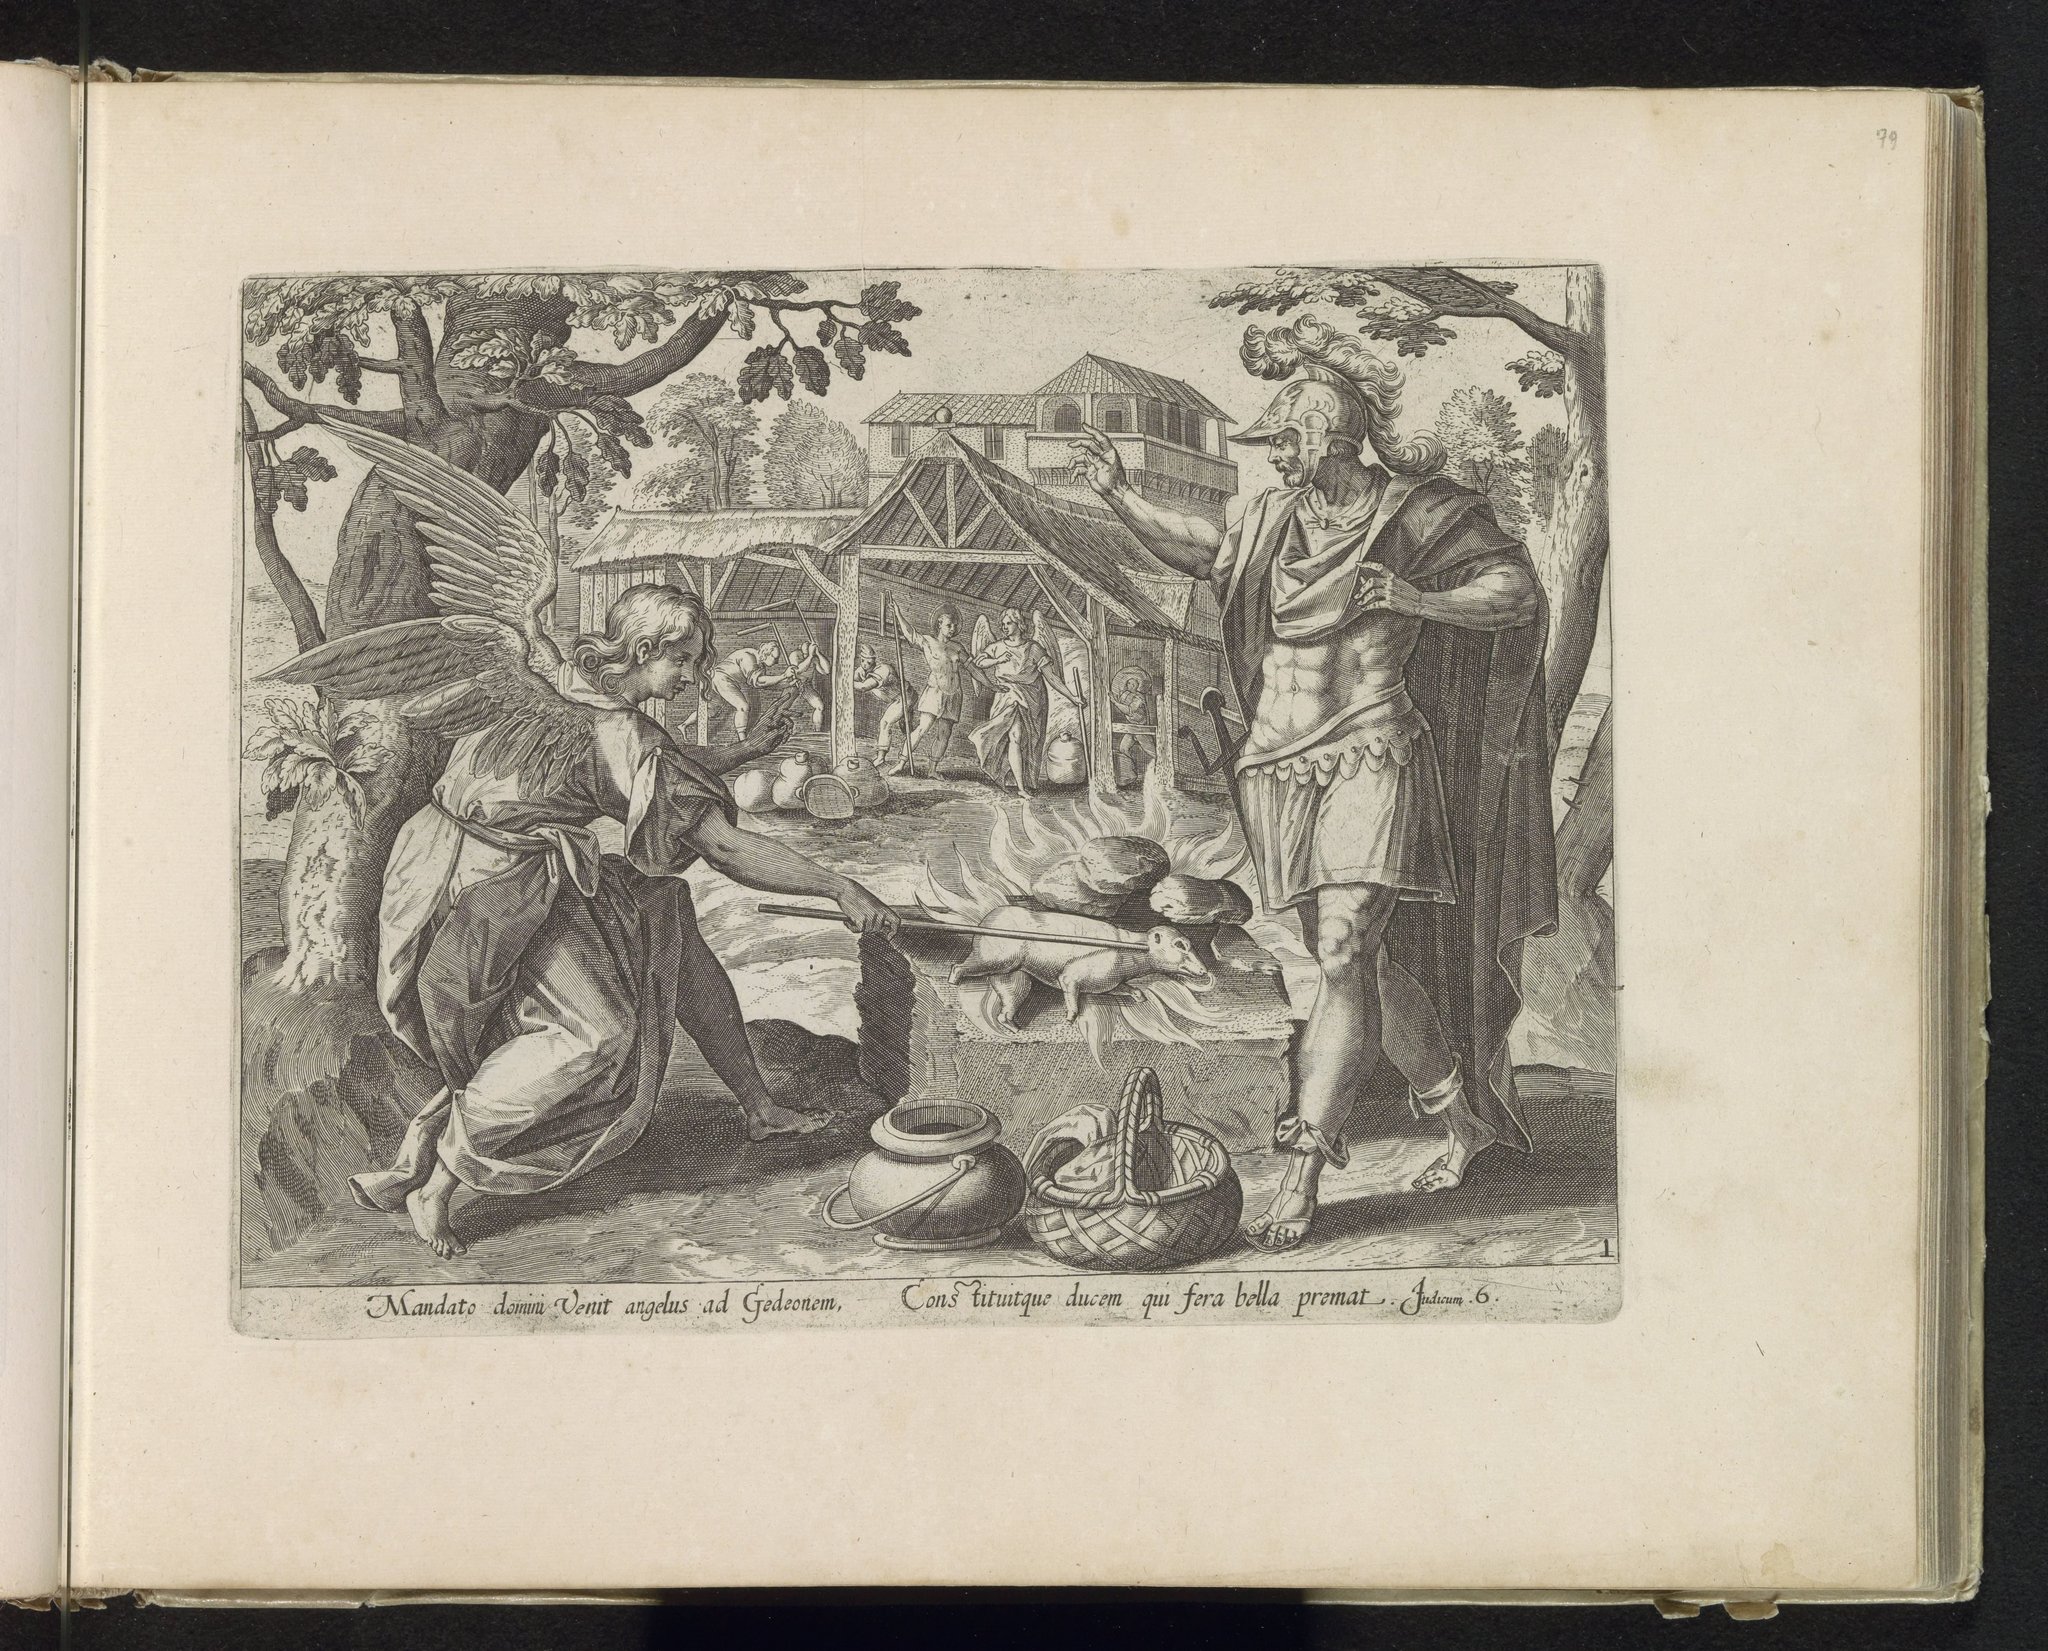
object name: album leaf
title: Thesaurus sacrarum historiaru[m] veteris testame[n]ti, elega[n]tissimis imaginibus expressu[m] excelle[n]tissimoru[m] in hac arte viroru[m] opera: nu[n]c primu[m] in luce[m] editus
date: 1585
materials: paper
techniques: engraving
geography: antwerp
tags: at the angel's request gideon puts the food on a rock and pours out the broth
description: De engel doet het geitenbokje en brood, dat Gideon heeft gebracht, ontvlammen. Op de achtergrond de scène die vooraf ging. Gideon ontmoet de engel op de dorsvloer. Gideon en andere mannen houden een dorsvlegel in de hand. Onder de voorstelling een verwijzing in het Latijn naar de Bijbeltekst in Ri. 6. Deze prent maakt deel uit van een album.